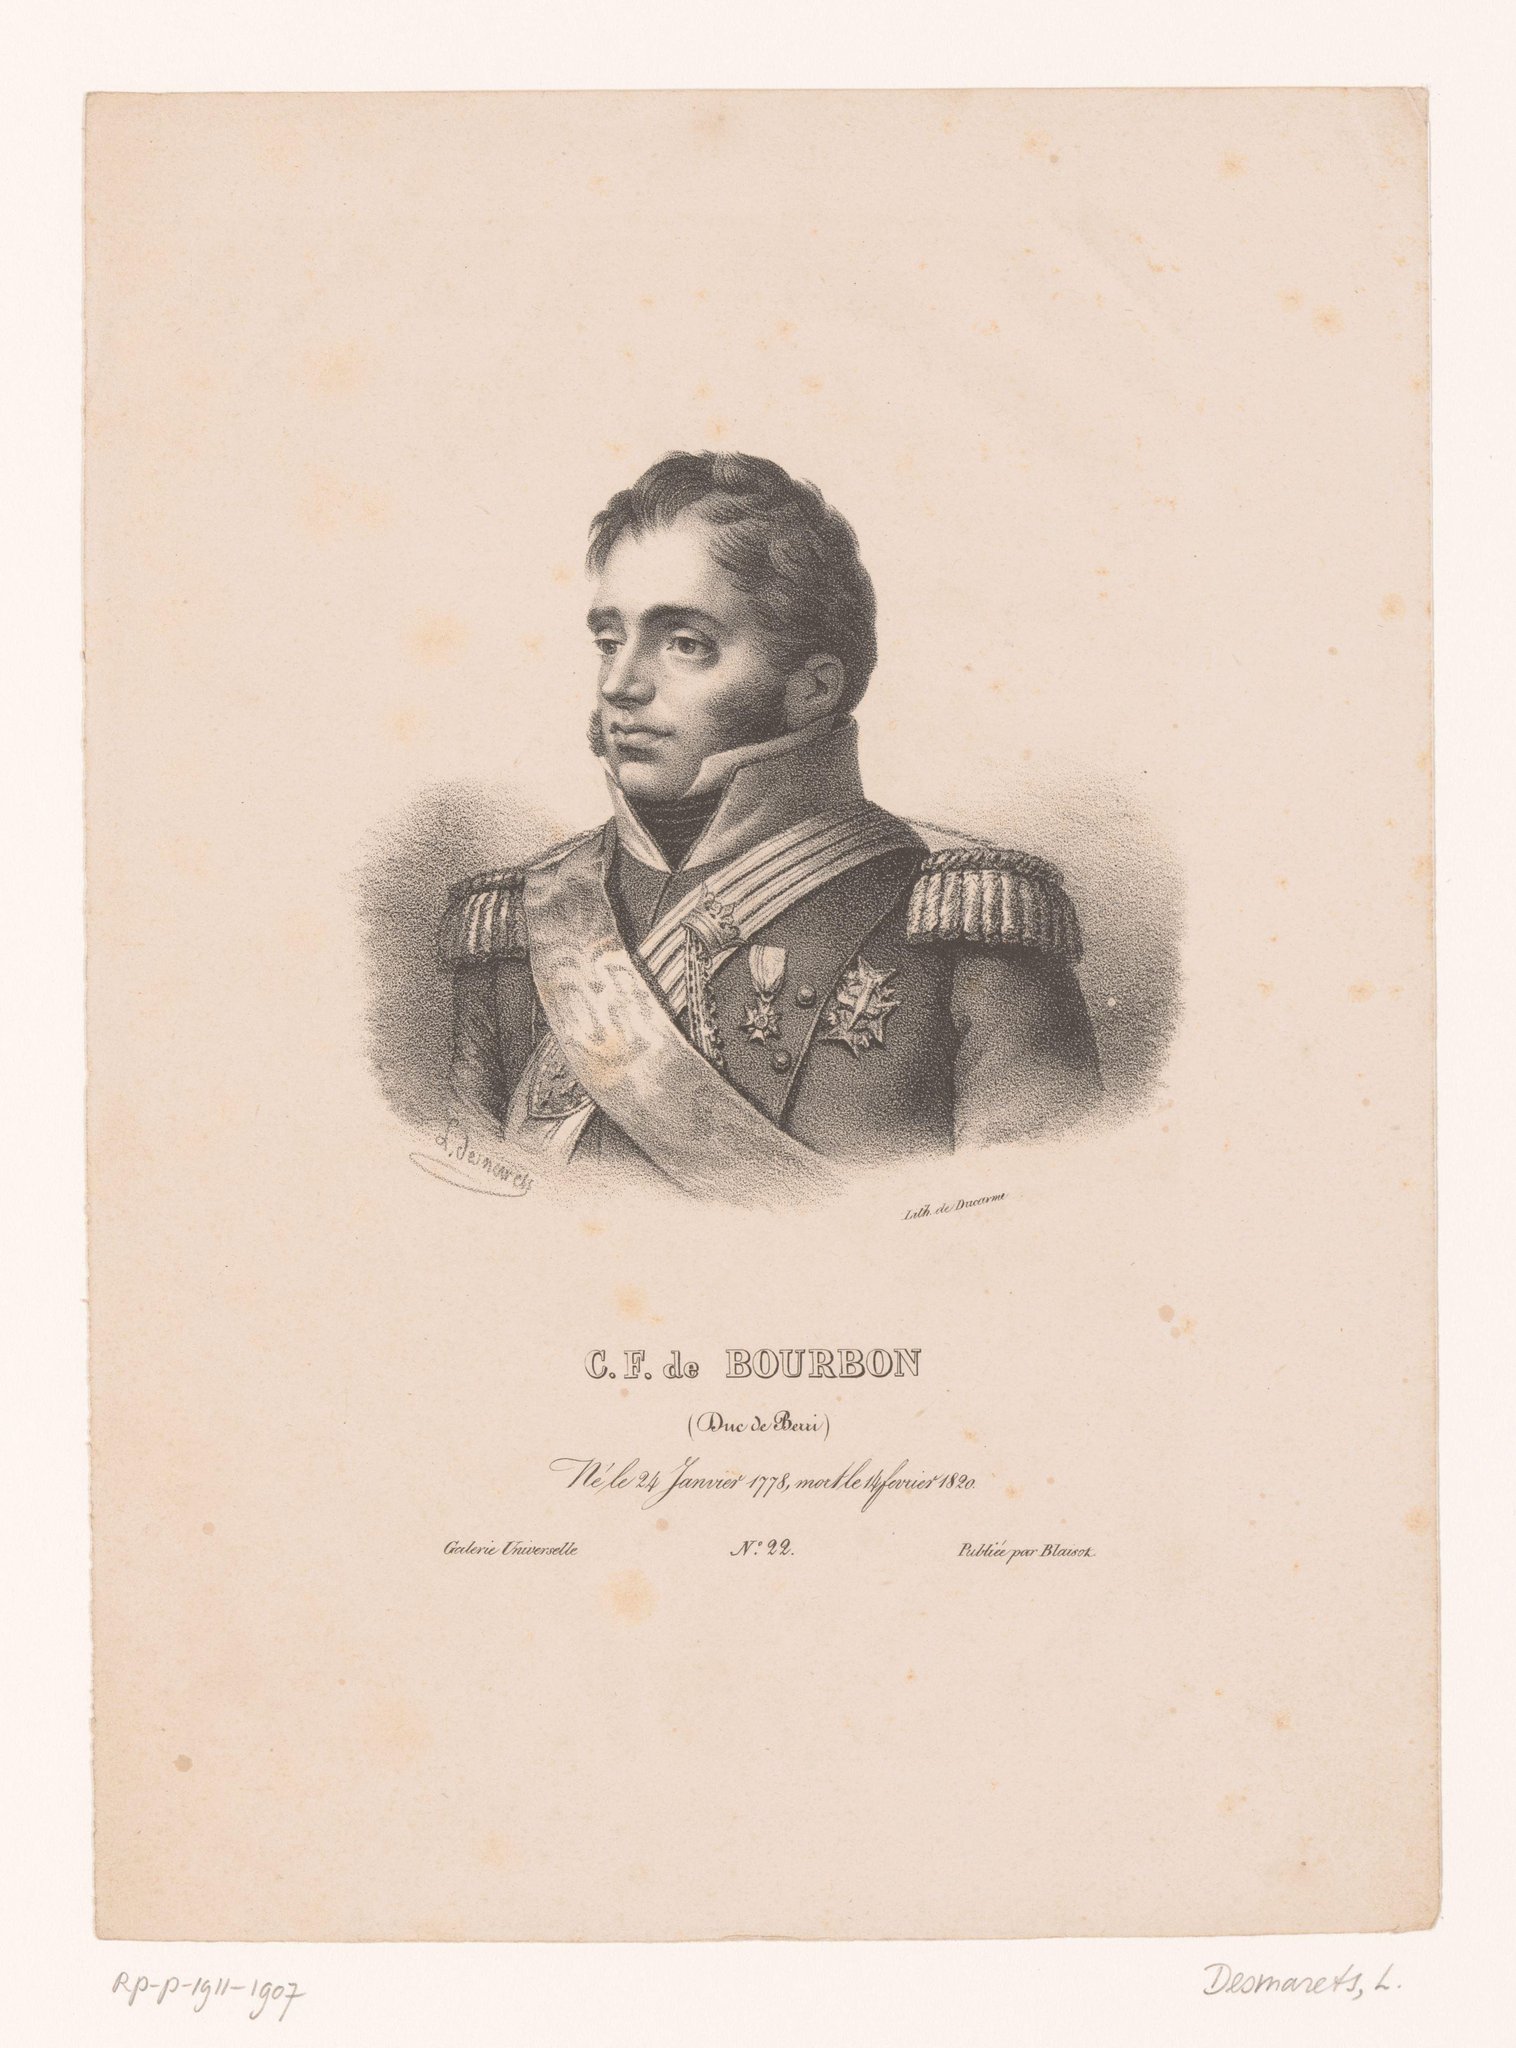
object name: print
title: C.F. de Bourbon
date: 1826-1827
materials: paper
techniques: lithograph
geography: paris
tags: historical persons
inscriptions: collector's mark: Lugt 2228a